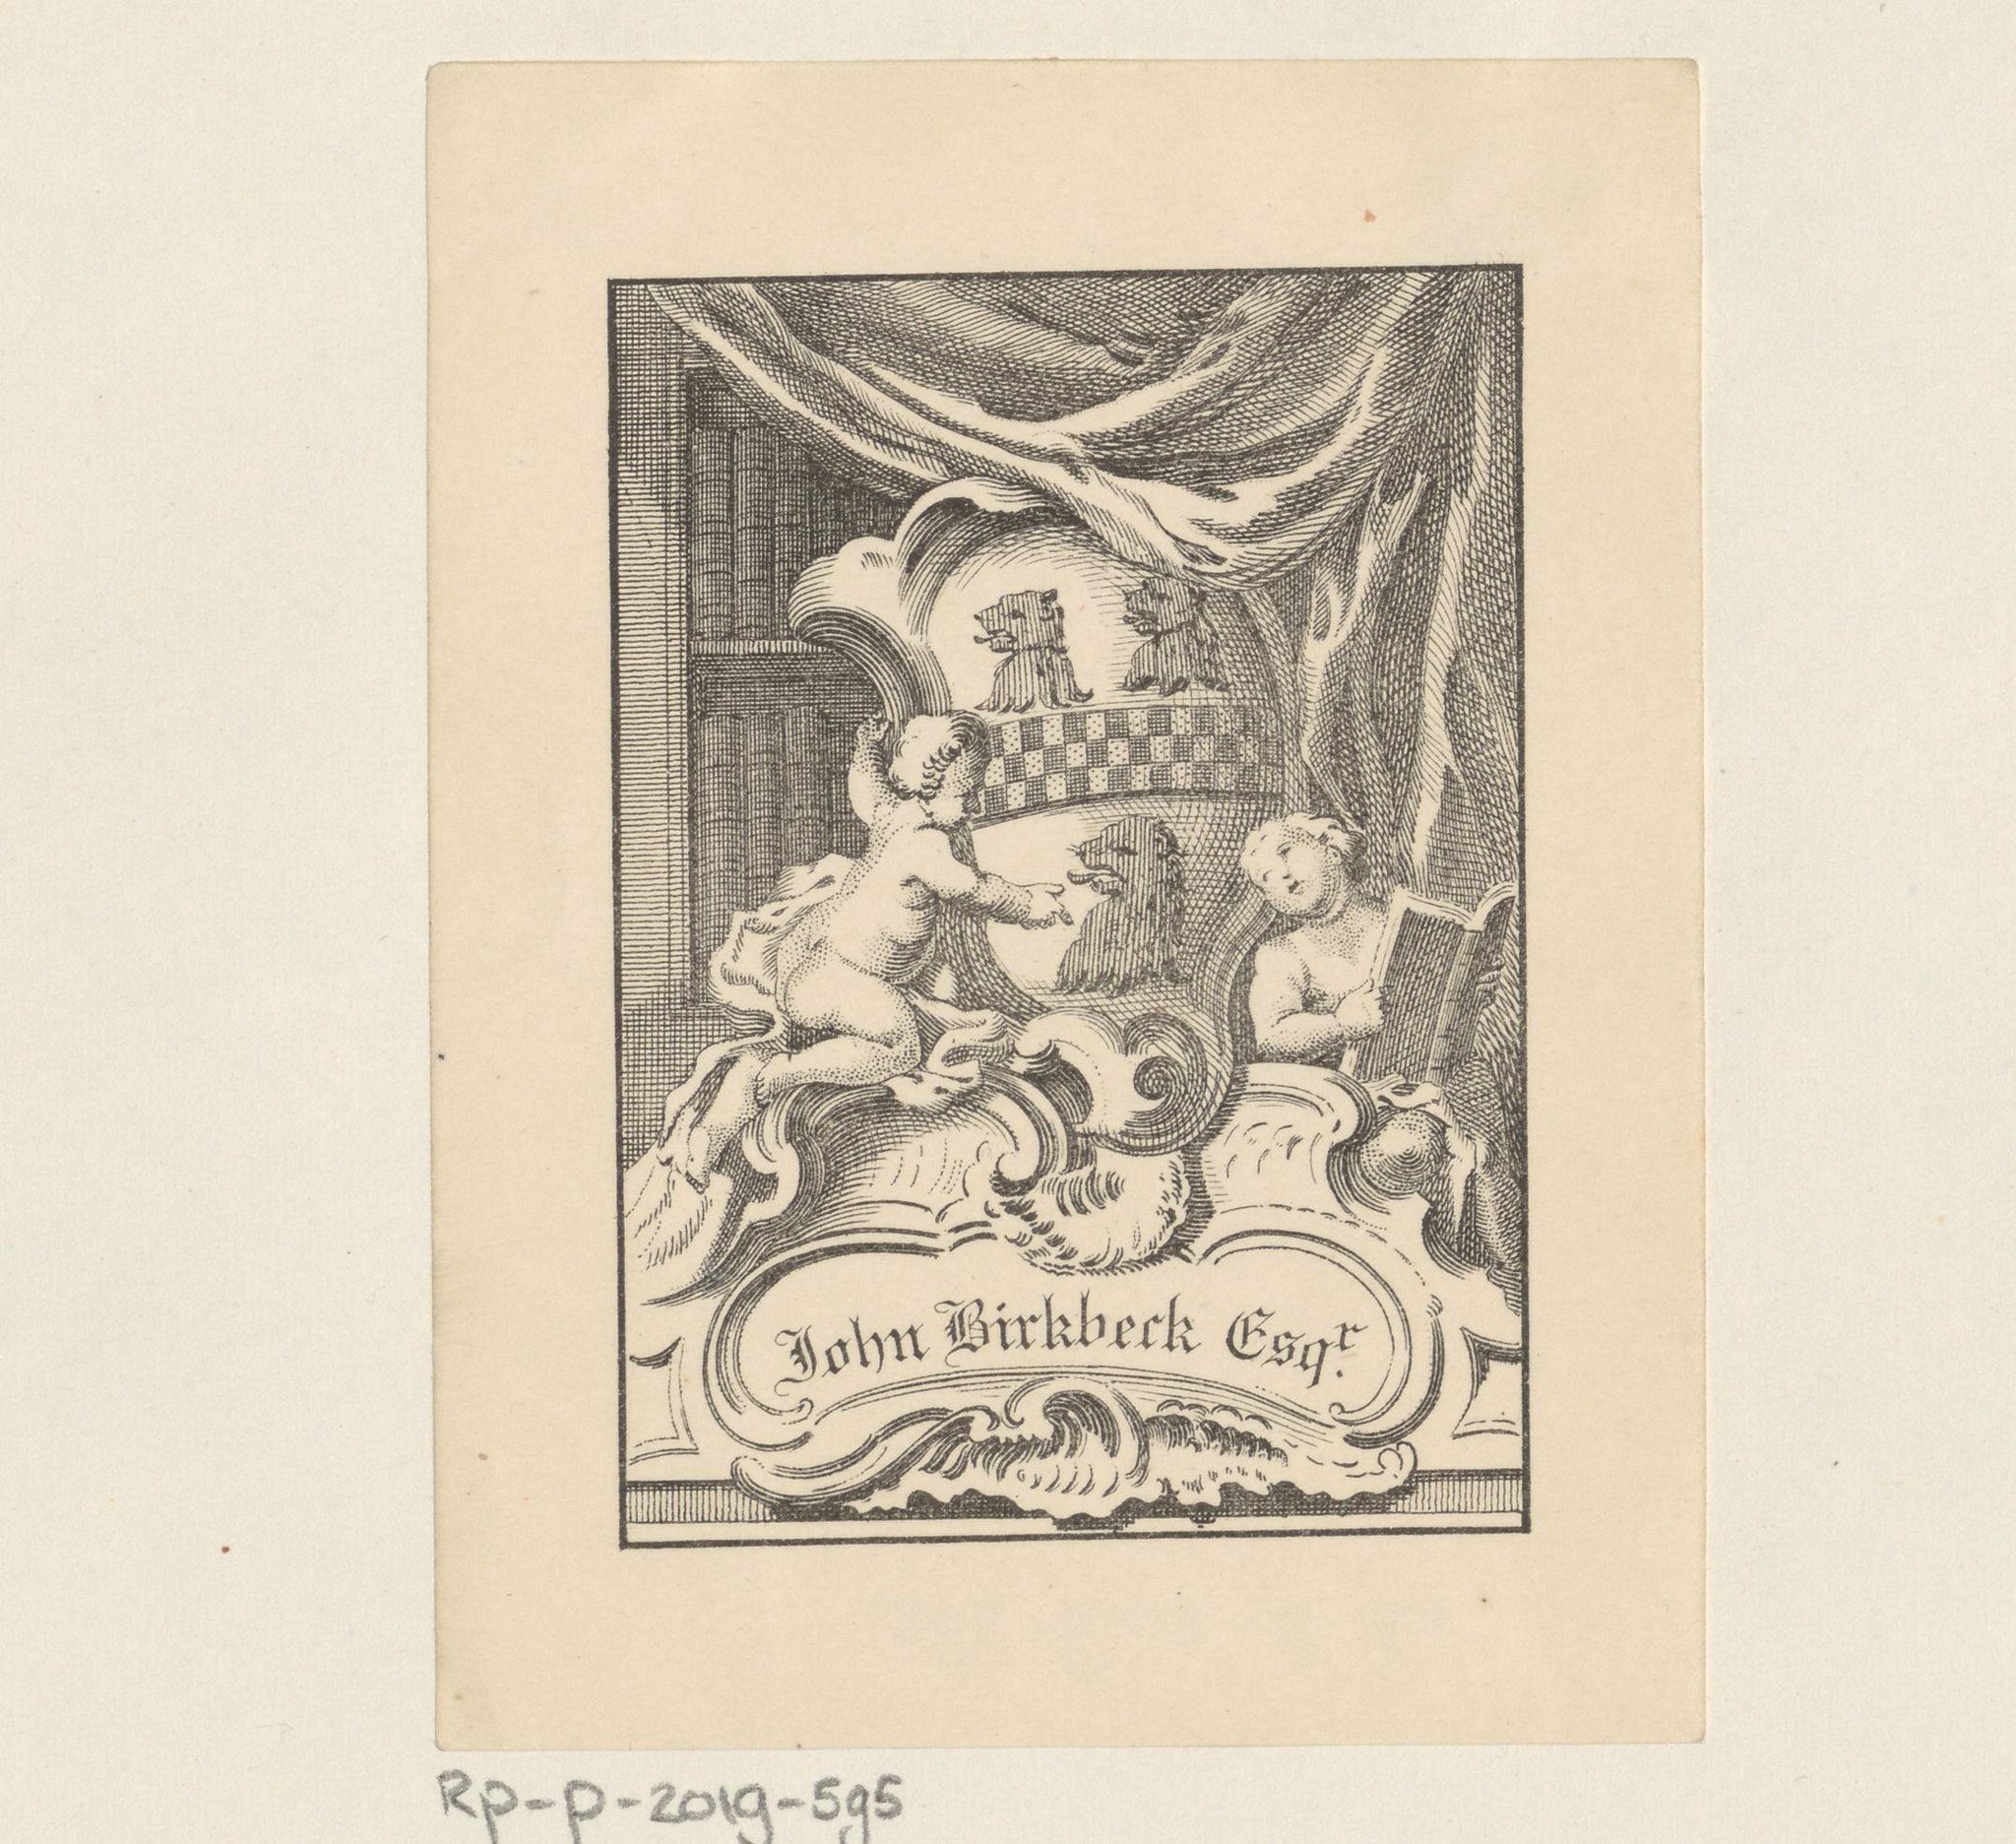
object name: bookplate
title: Ex libris van John Birkbeck Esqr.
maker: Anonymous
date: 1800-1899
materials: paper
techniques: engraving, etching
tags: study; 'studiolo'; library